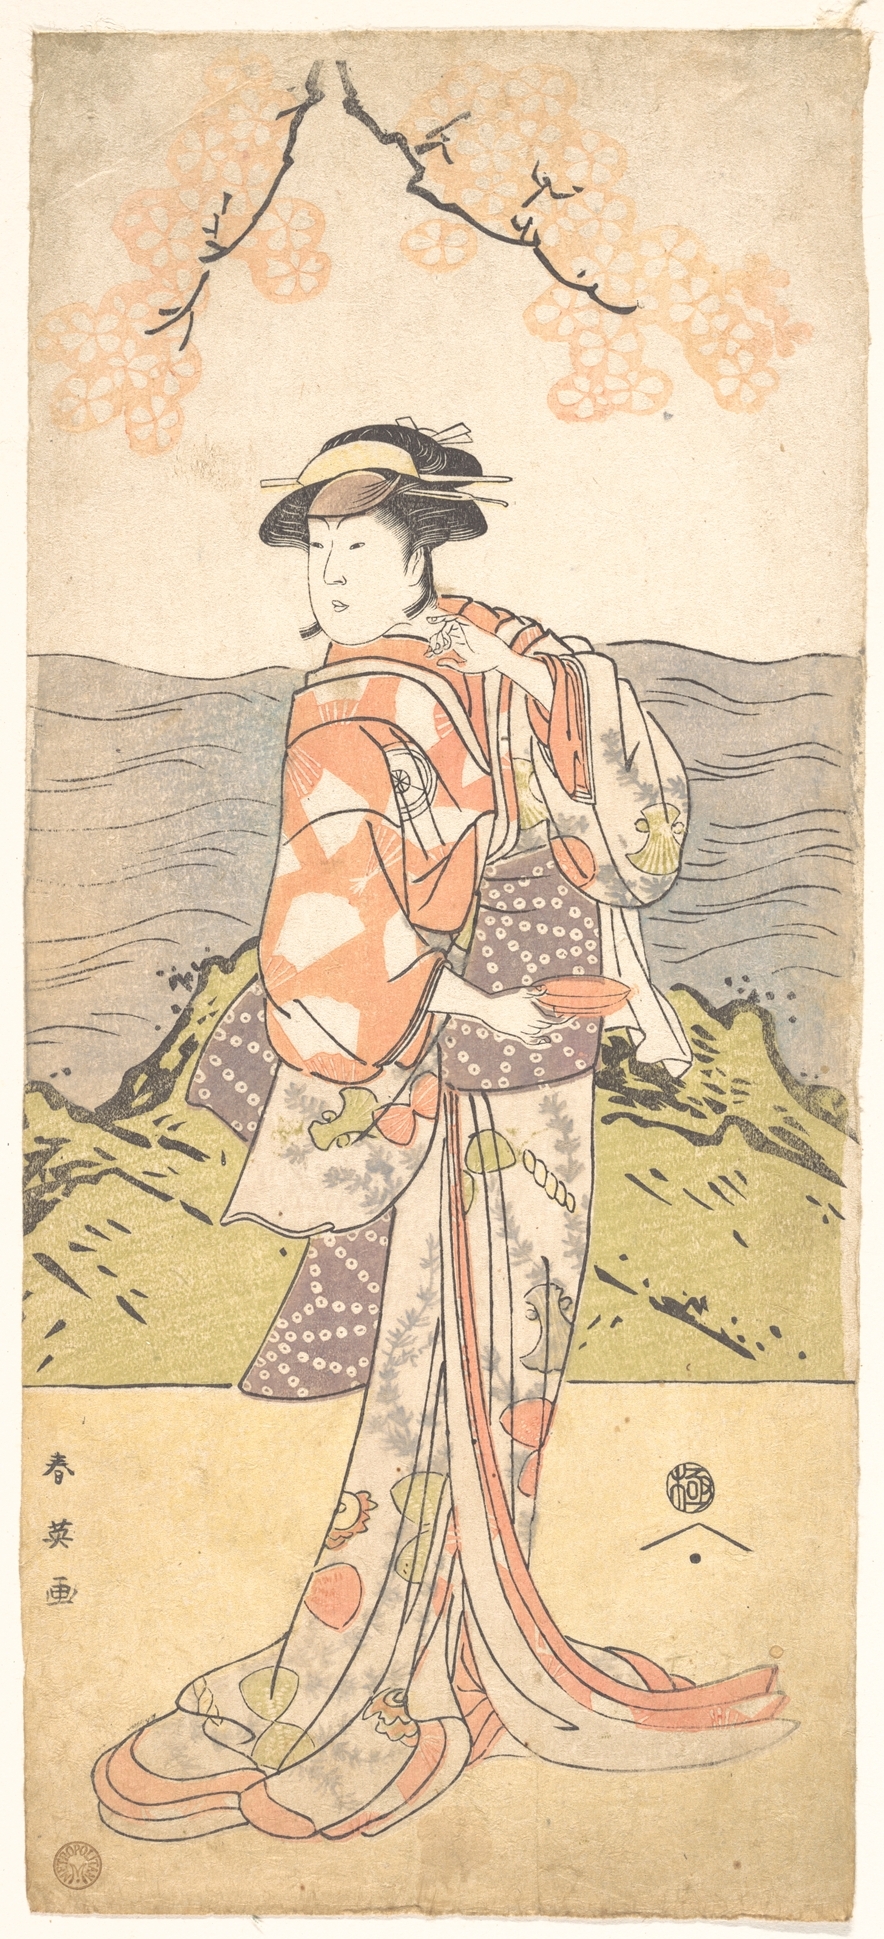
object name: print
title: The Fourth Iwai Hanshiro as a Woman Standing Beneath a Cherry Tree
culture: japanese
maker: katsukawa shun'ei 勝川春英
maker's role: artist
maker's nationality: japanese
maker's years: 1762-1819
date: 1792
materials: ink, paper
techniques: woodblock print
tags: men,trees,actors